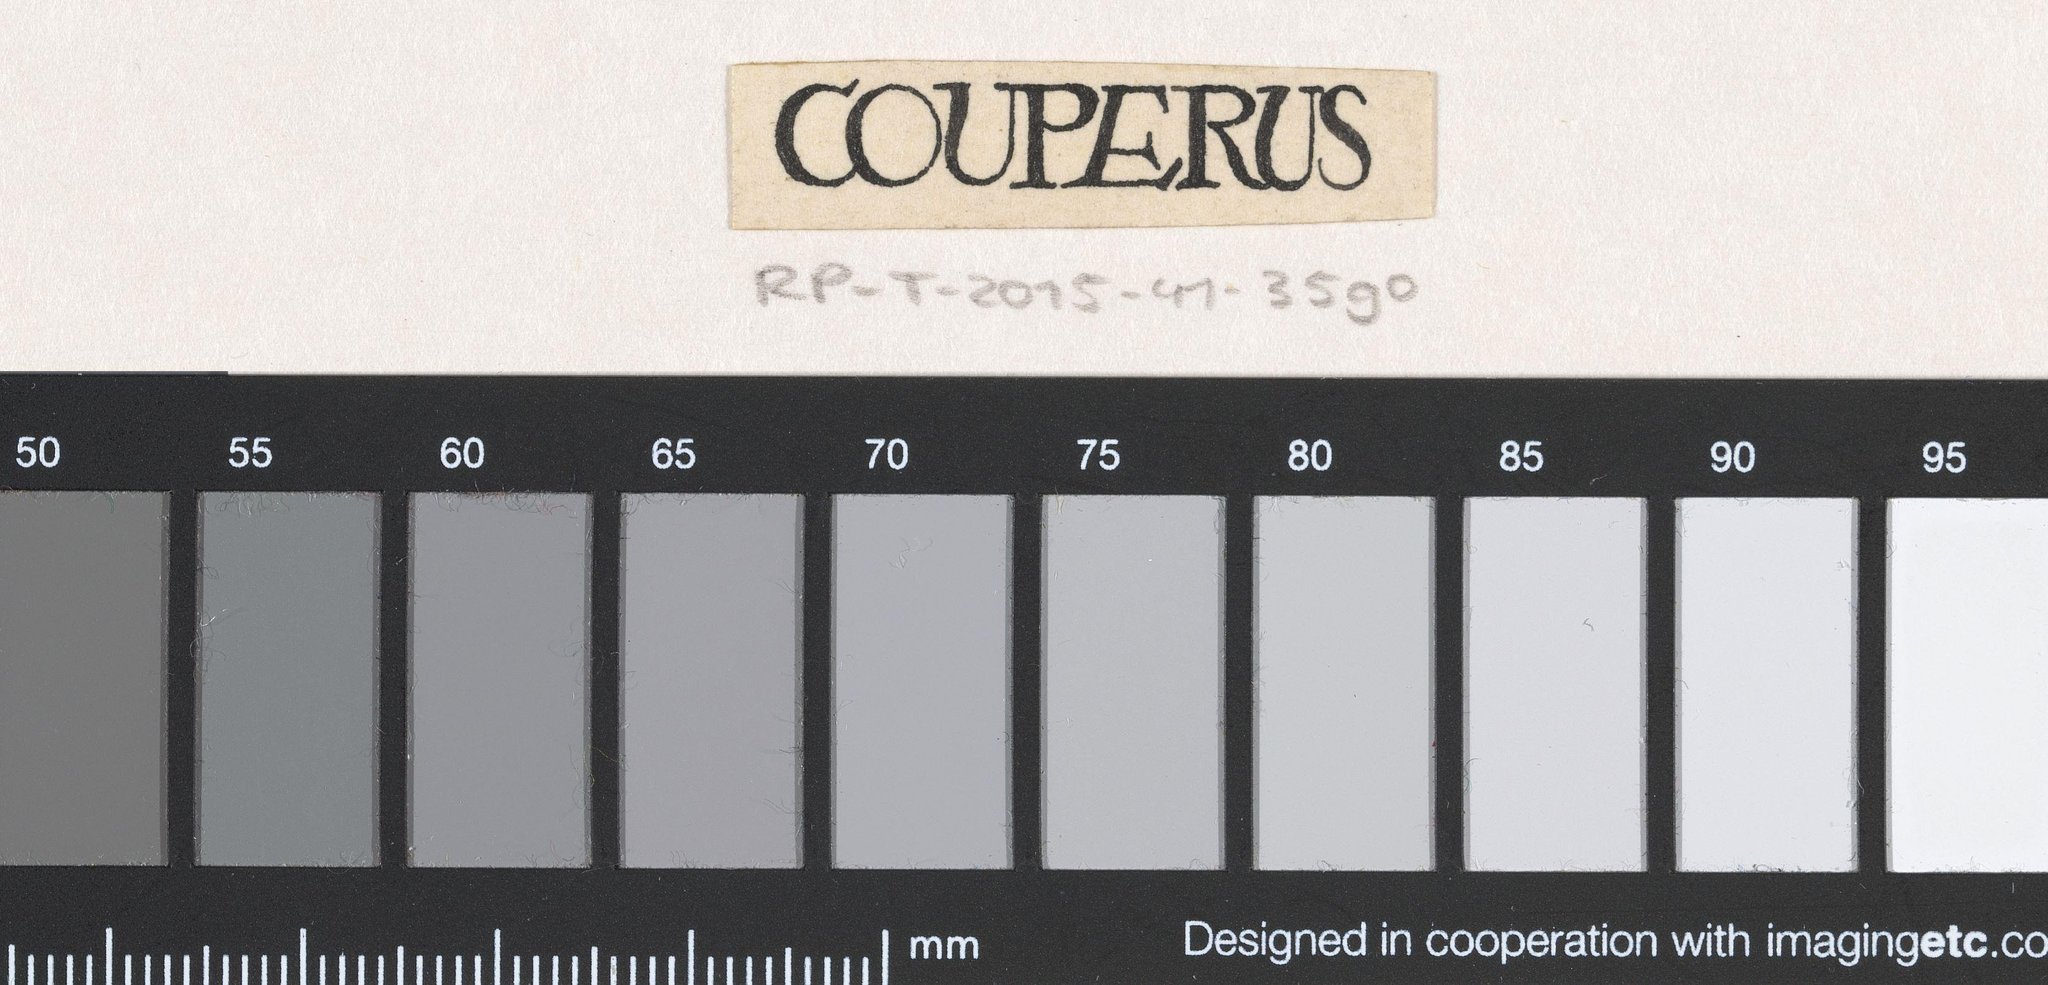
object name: drawing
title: Letterontwerp 'Couperus'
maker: Anonymous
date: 1890-1930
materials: ink, paper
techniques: pen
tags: fancy letters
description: Letterontwerp voor een boekband van één van de werken van Louis Couperus.